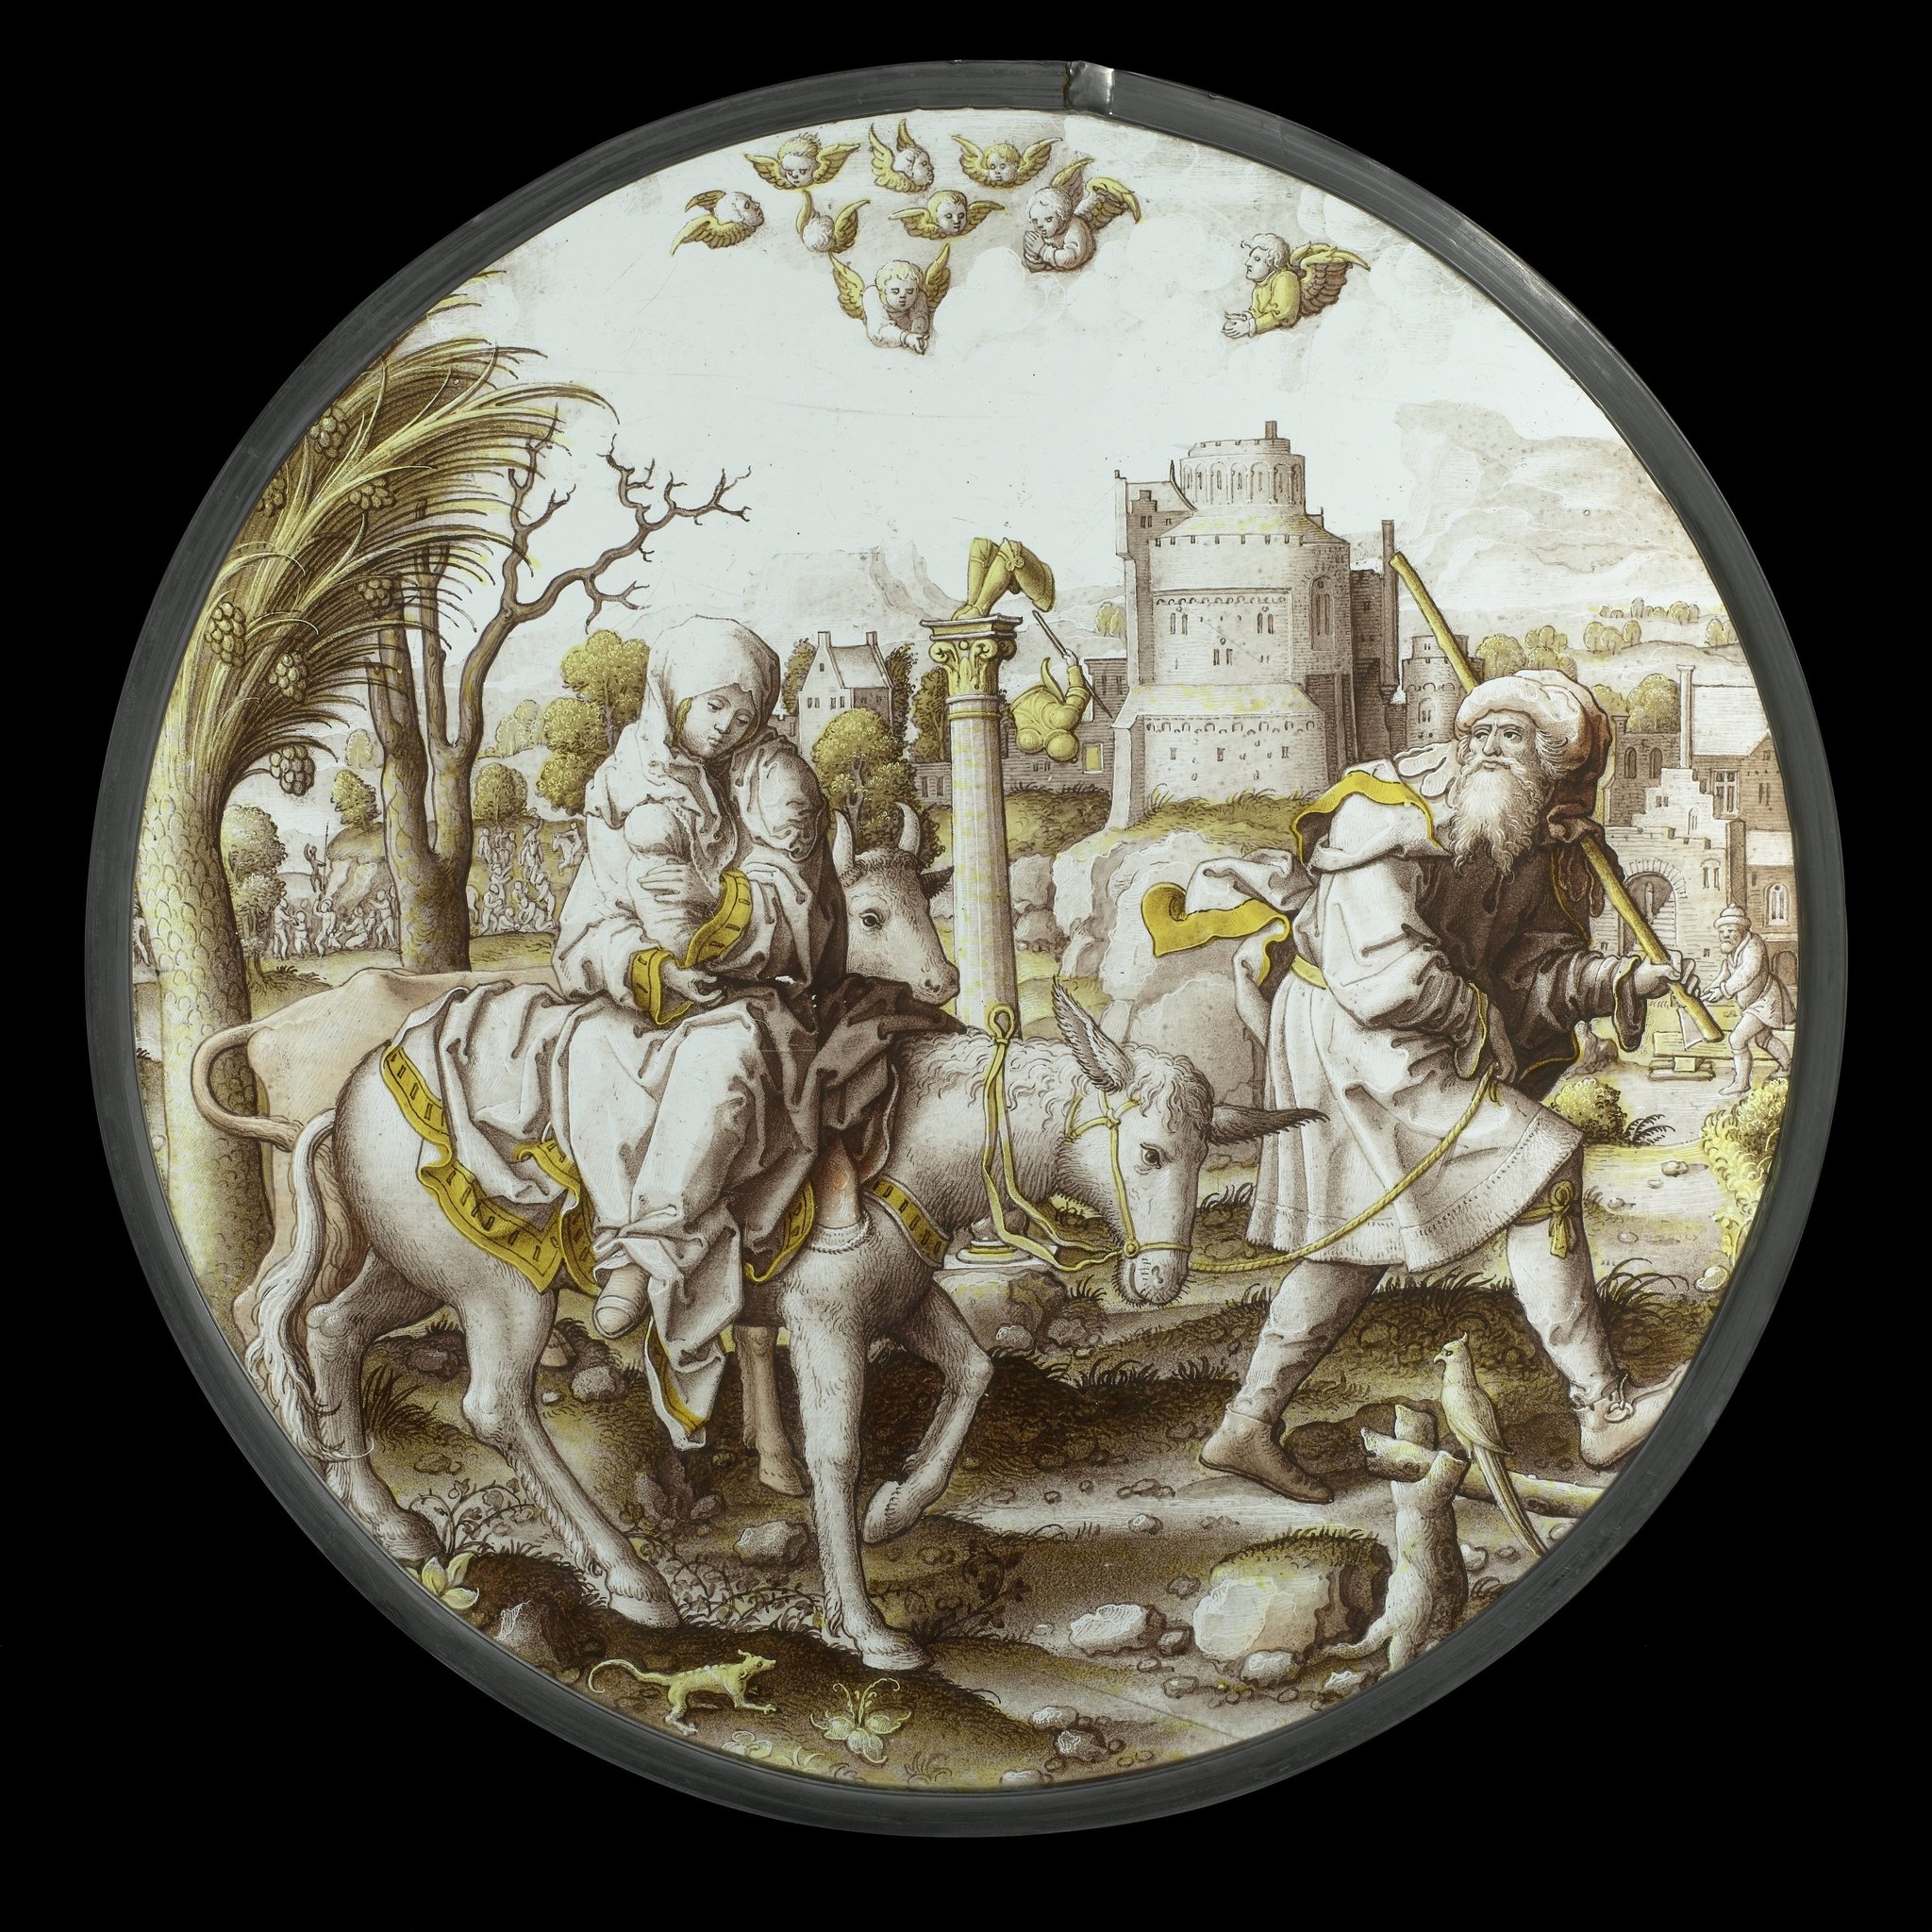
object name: light window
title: The Flight into Egypt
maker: dirck vellert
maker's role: draughtsman, painter, print maker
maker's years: 1480-1547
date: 1532-1540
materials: glass, lead, pigment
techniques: leading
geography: nuremberg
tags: falling of the idols ~ miracles during the flight into egypt, the flight into egypt: mary, joseph, the child (and sometimes others) on their way; mary usually riding on an ass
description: Ronde gebrandschilderde ruit met voorstelling van de Vlucht naar Egypte. Maria zit schrijlings op de ezel, die door Jozef aan een leidsel wordt meegevoerd. Het in doeken gewikkelde Christuskind houdt zij beschermend in haar armen. Een os vergezelt hen, als verwijzing naar de geboorte van Christus. Op de achtergrond een landschap met een kasteel en een stad. Links op de achtergrond is de kindermoord te zien. In het midden is het wonder uitgebeeld, dat de heidense godenbeelden van de Egyptenaren van hun voetstukken vielen en in stuken braken, toen het Christuskind voor hen verscheen.